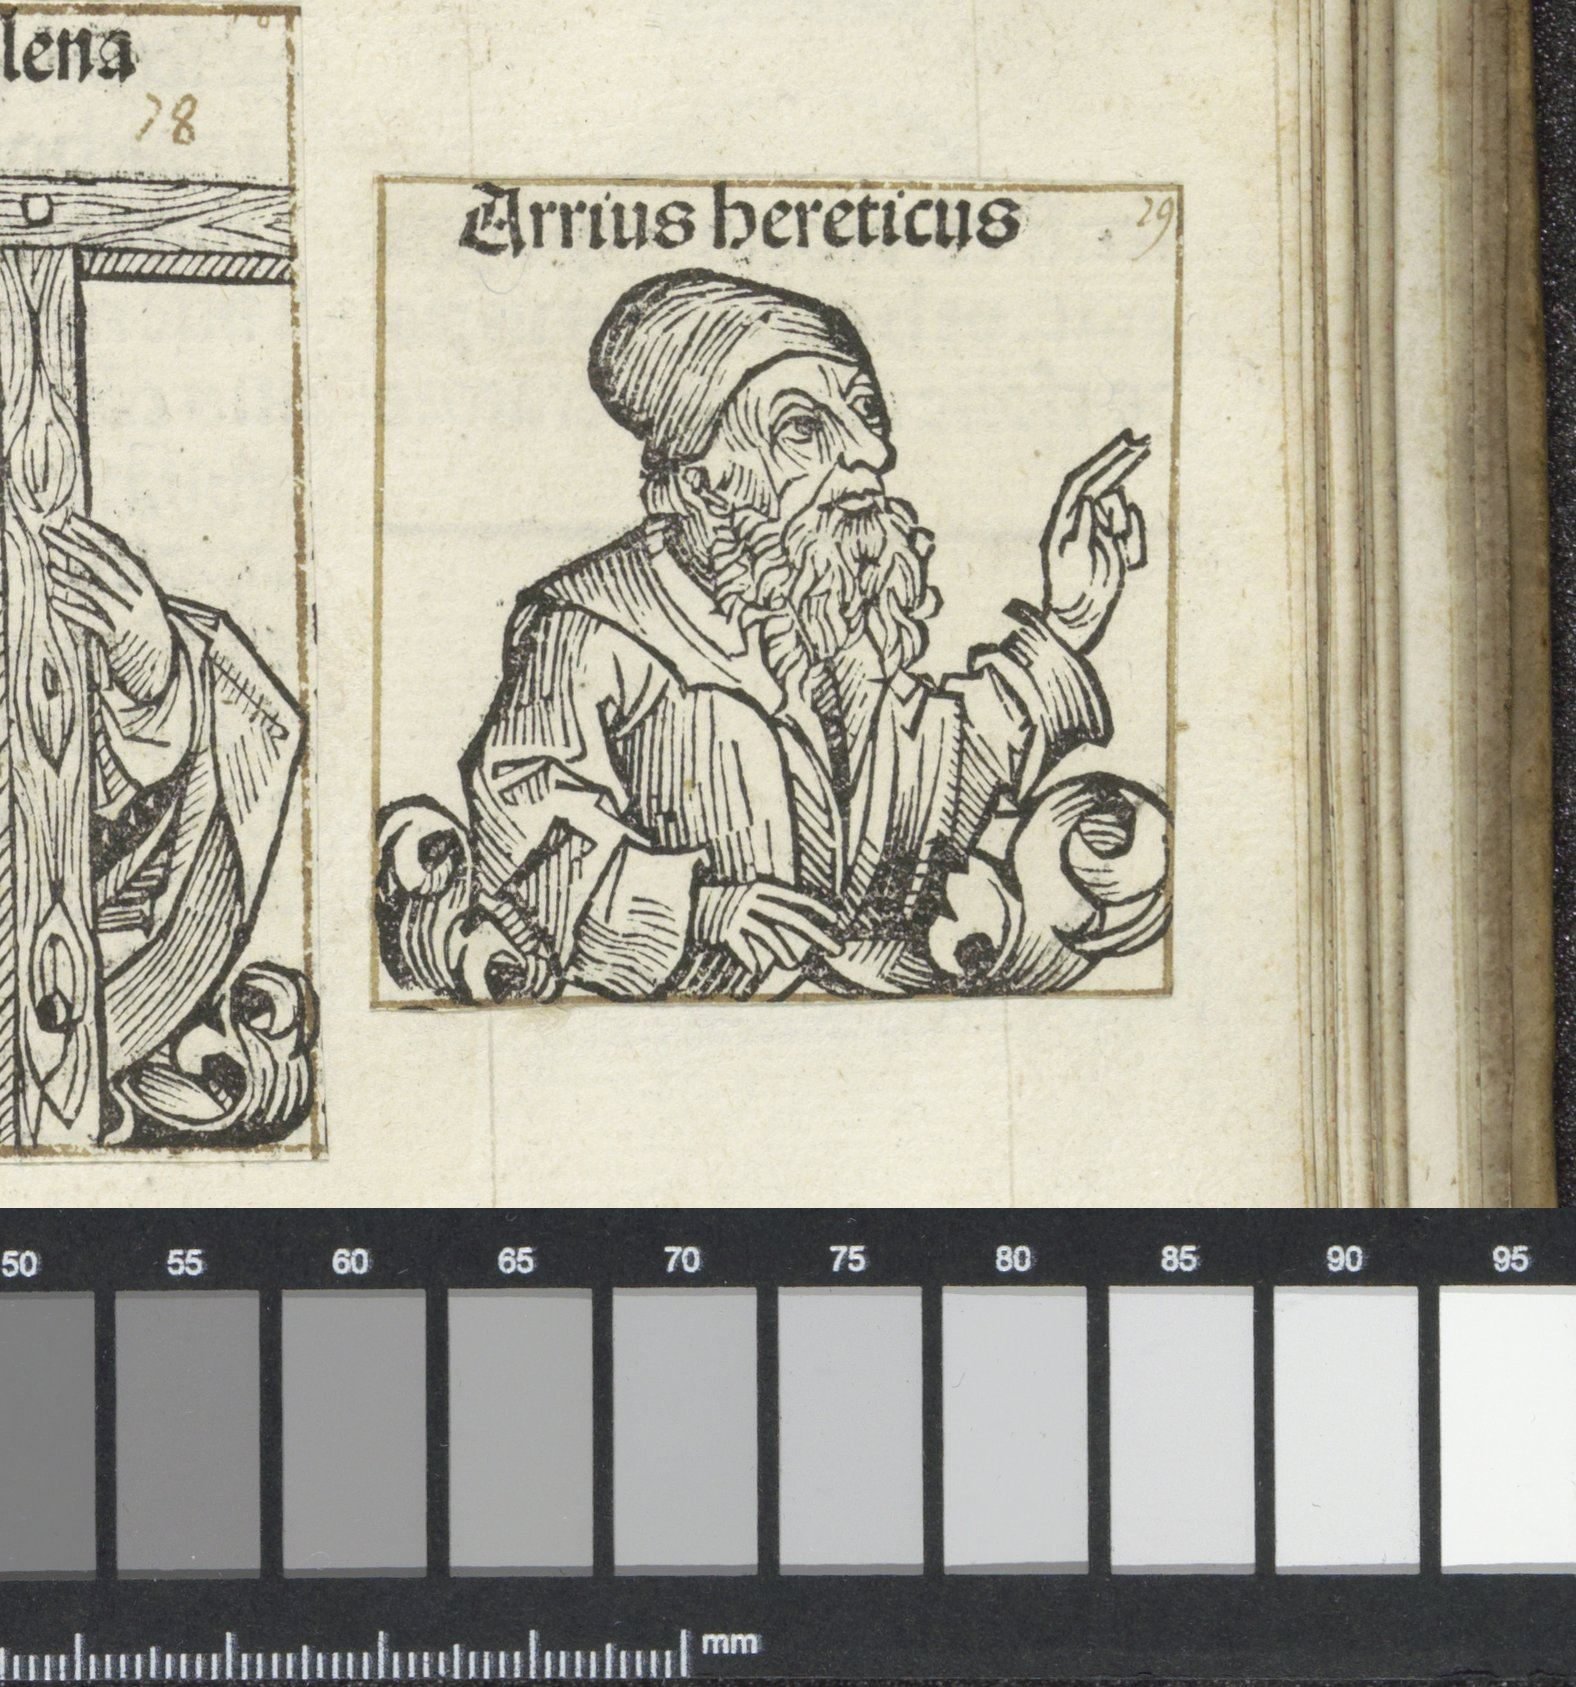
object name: album leaf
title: Arrius hereticus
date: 1493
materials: paper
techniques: letterpress printing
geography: nuremberg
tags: priest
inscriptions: inscription: ‘79’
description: De houtsnede wordt herhaaldelijk gebruikt als boekillustratie in de Liber Chronicarum (of Neurenbergkroniek) van Hartmann Schedel, verschenen in het Latijn en Duits in 1493. Zie de Latijnse uitgave, folio 130v.